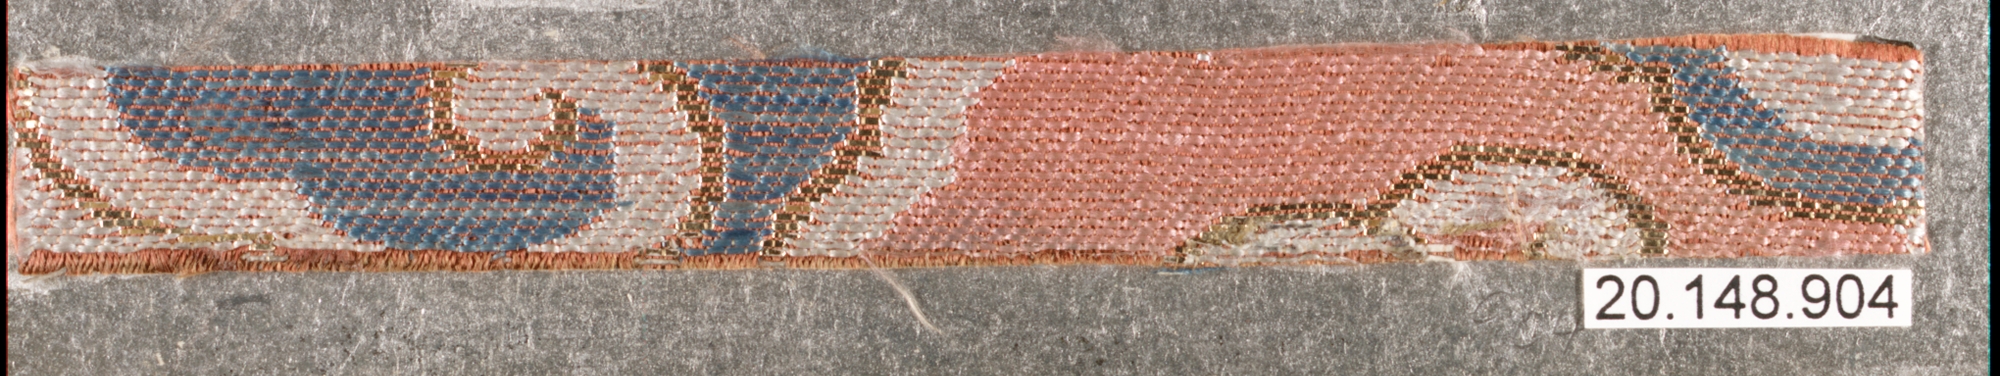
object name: piece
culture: japanese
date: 1701-1800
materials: silk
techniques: compound weave